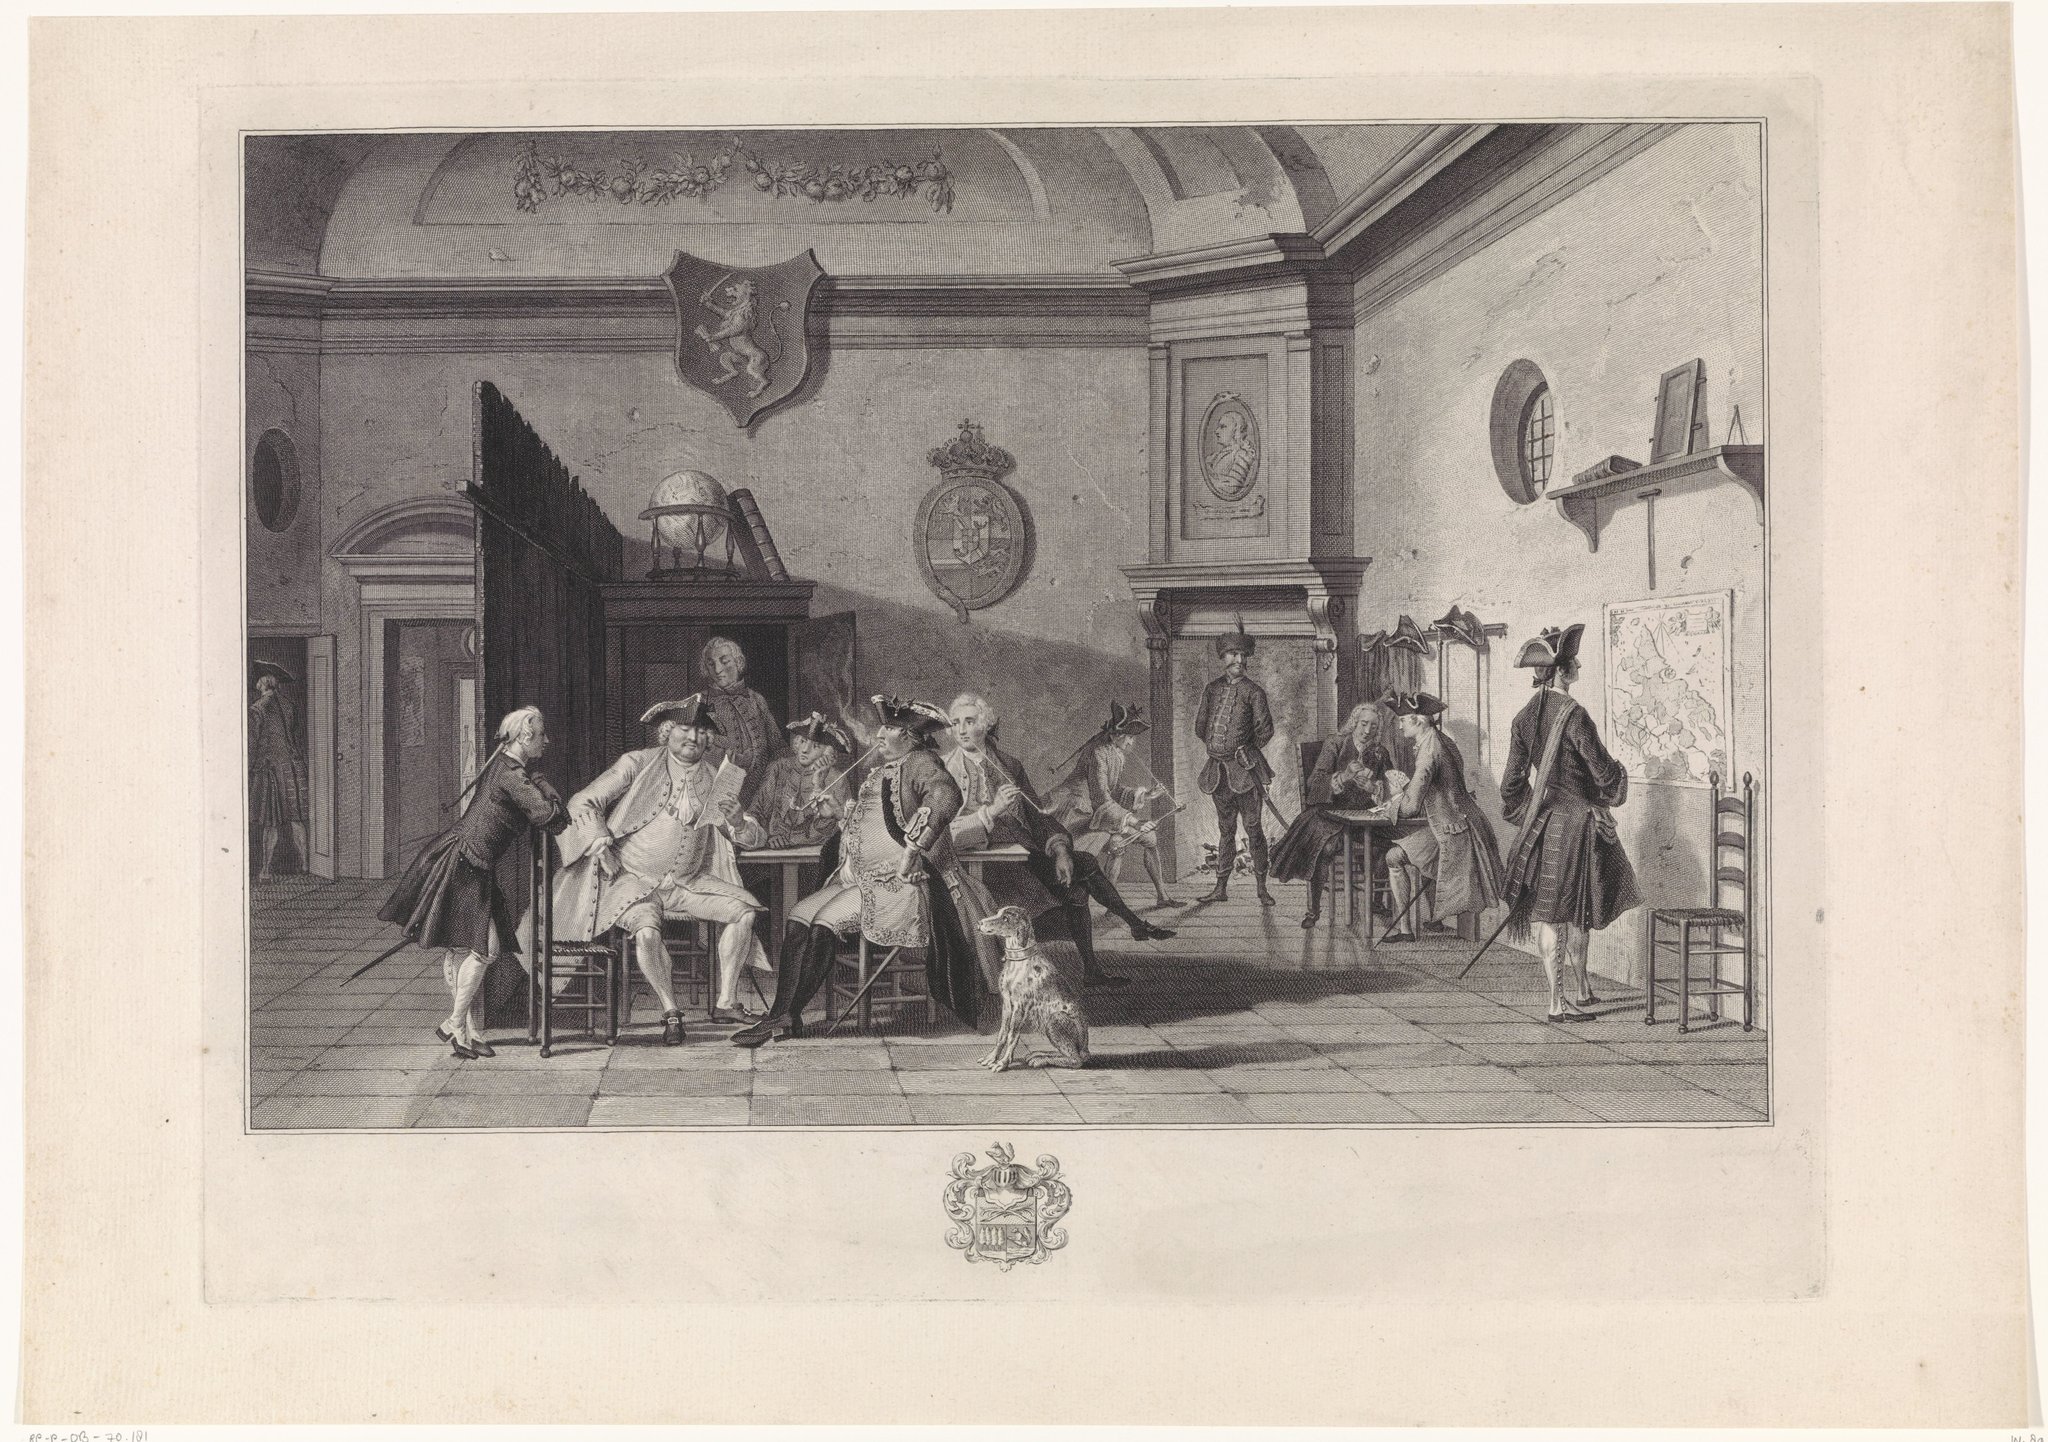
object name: print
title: Wachtlokaal met lezende, rokende en kaartspelende officieren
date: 1754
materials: paper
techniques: engraving, etching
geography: amsterdam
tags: maps of separate countries or regions, in the guard-room, 'kortegaard', officer, dog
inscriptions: collector's mark: Lugt 240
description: Wachtlokaal met lezende, rokende en kaartspelende officieren. Rechts bestudeert een van hen een kaart van de Nederlanden. Aan de muur een wapenschild met de Hollandse Leeuw. Onderaan in de marge het wapenschild van Gerrit Braamcamp, die het originele schilderij in zijn verzameling had.